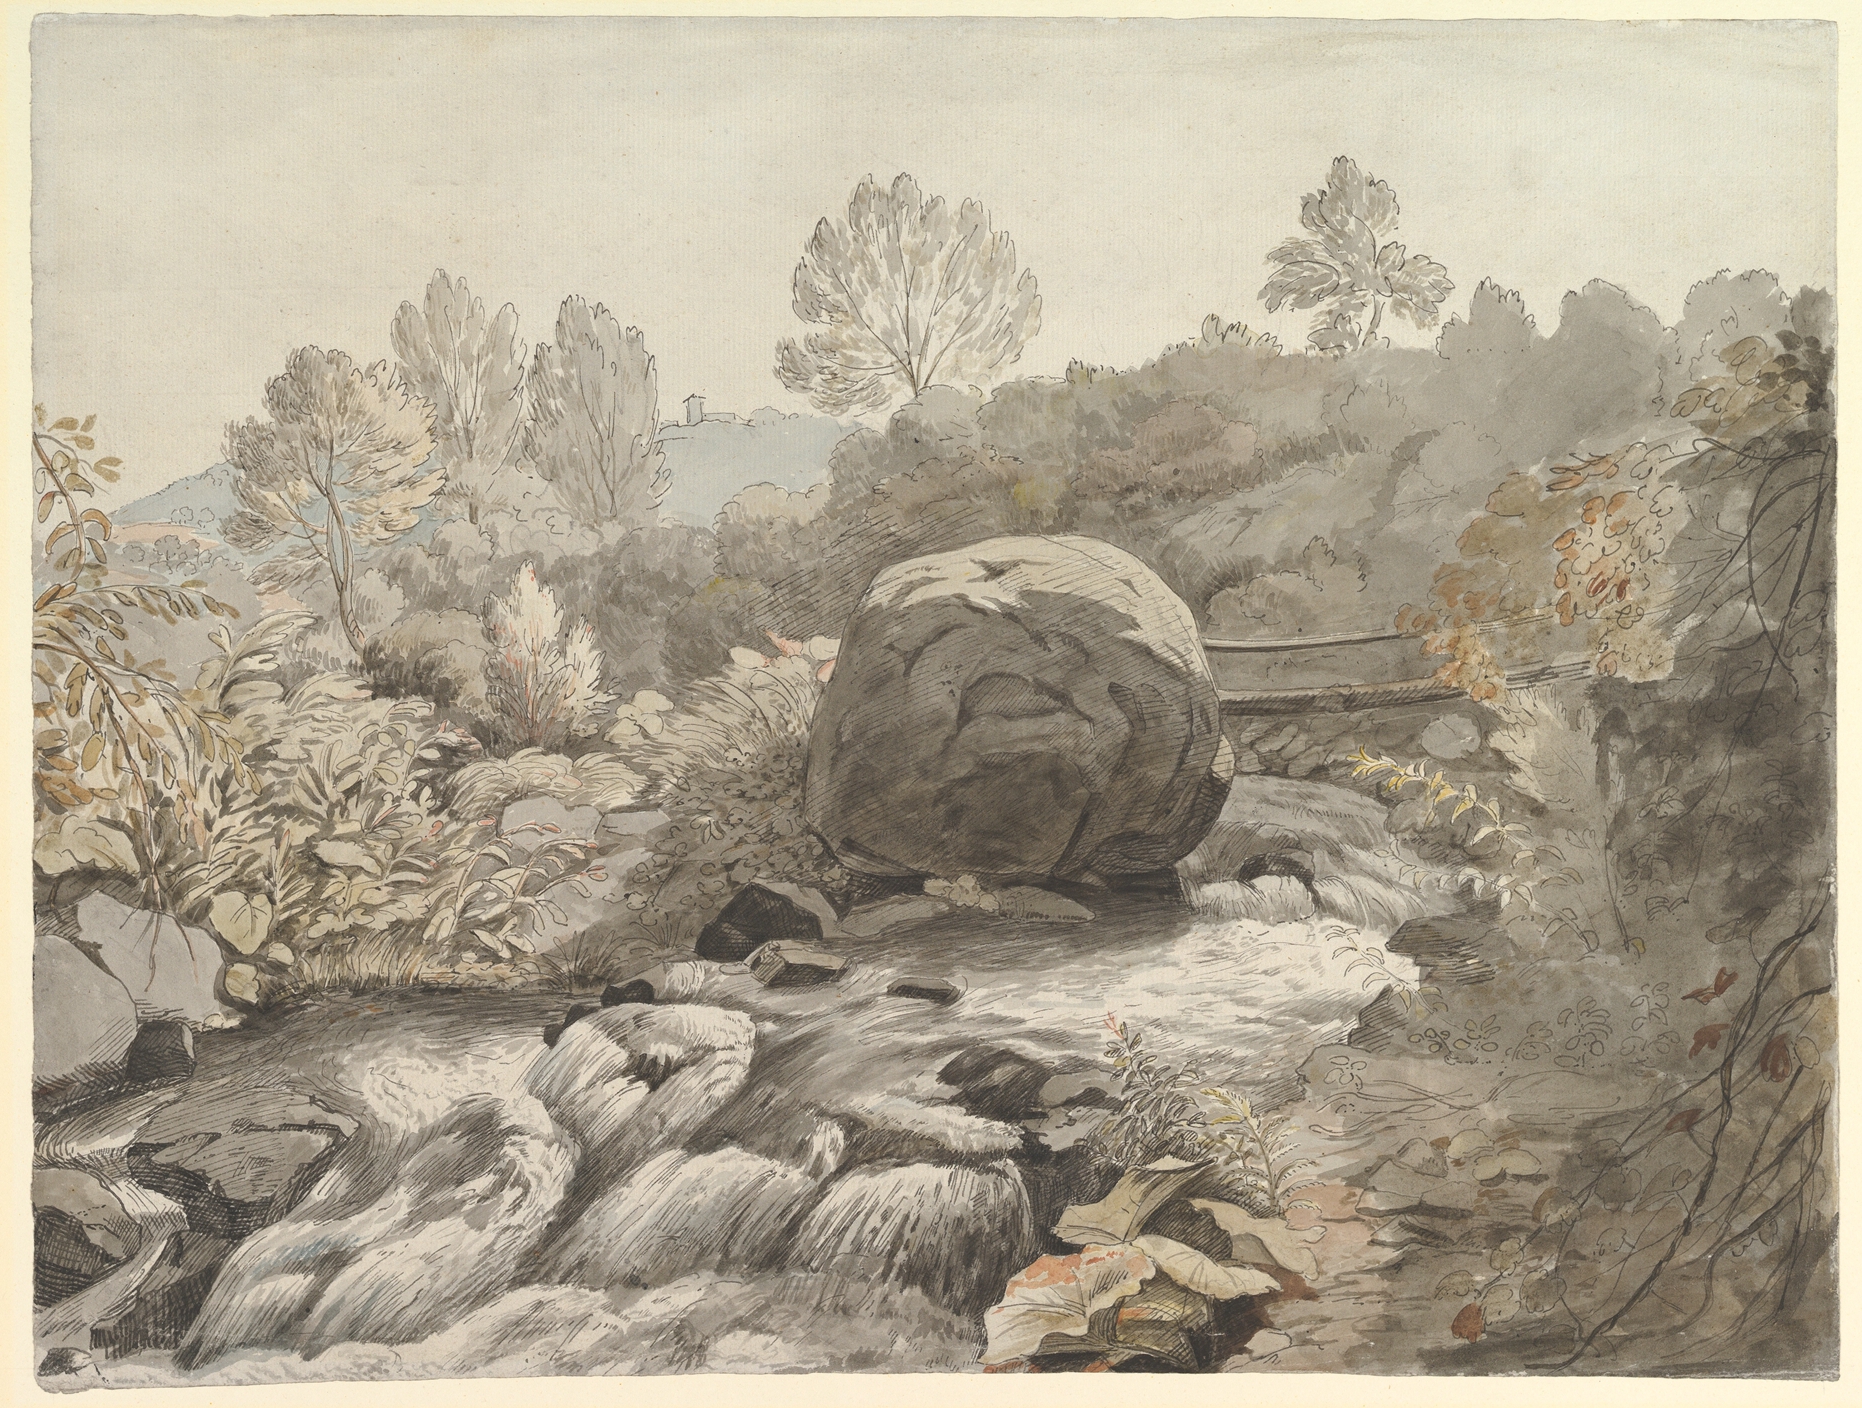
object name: drawing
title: A rocky stream, Italy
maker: samuel woodforde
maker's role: artist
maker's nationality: british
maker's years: 1763-1817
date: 1786-1791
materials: graphite, ink, watercolor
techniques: pen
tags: landscapes,streams